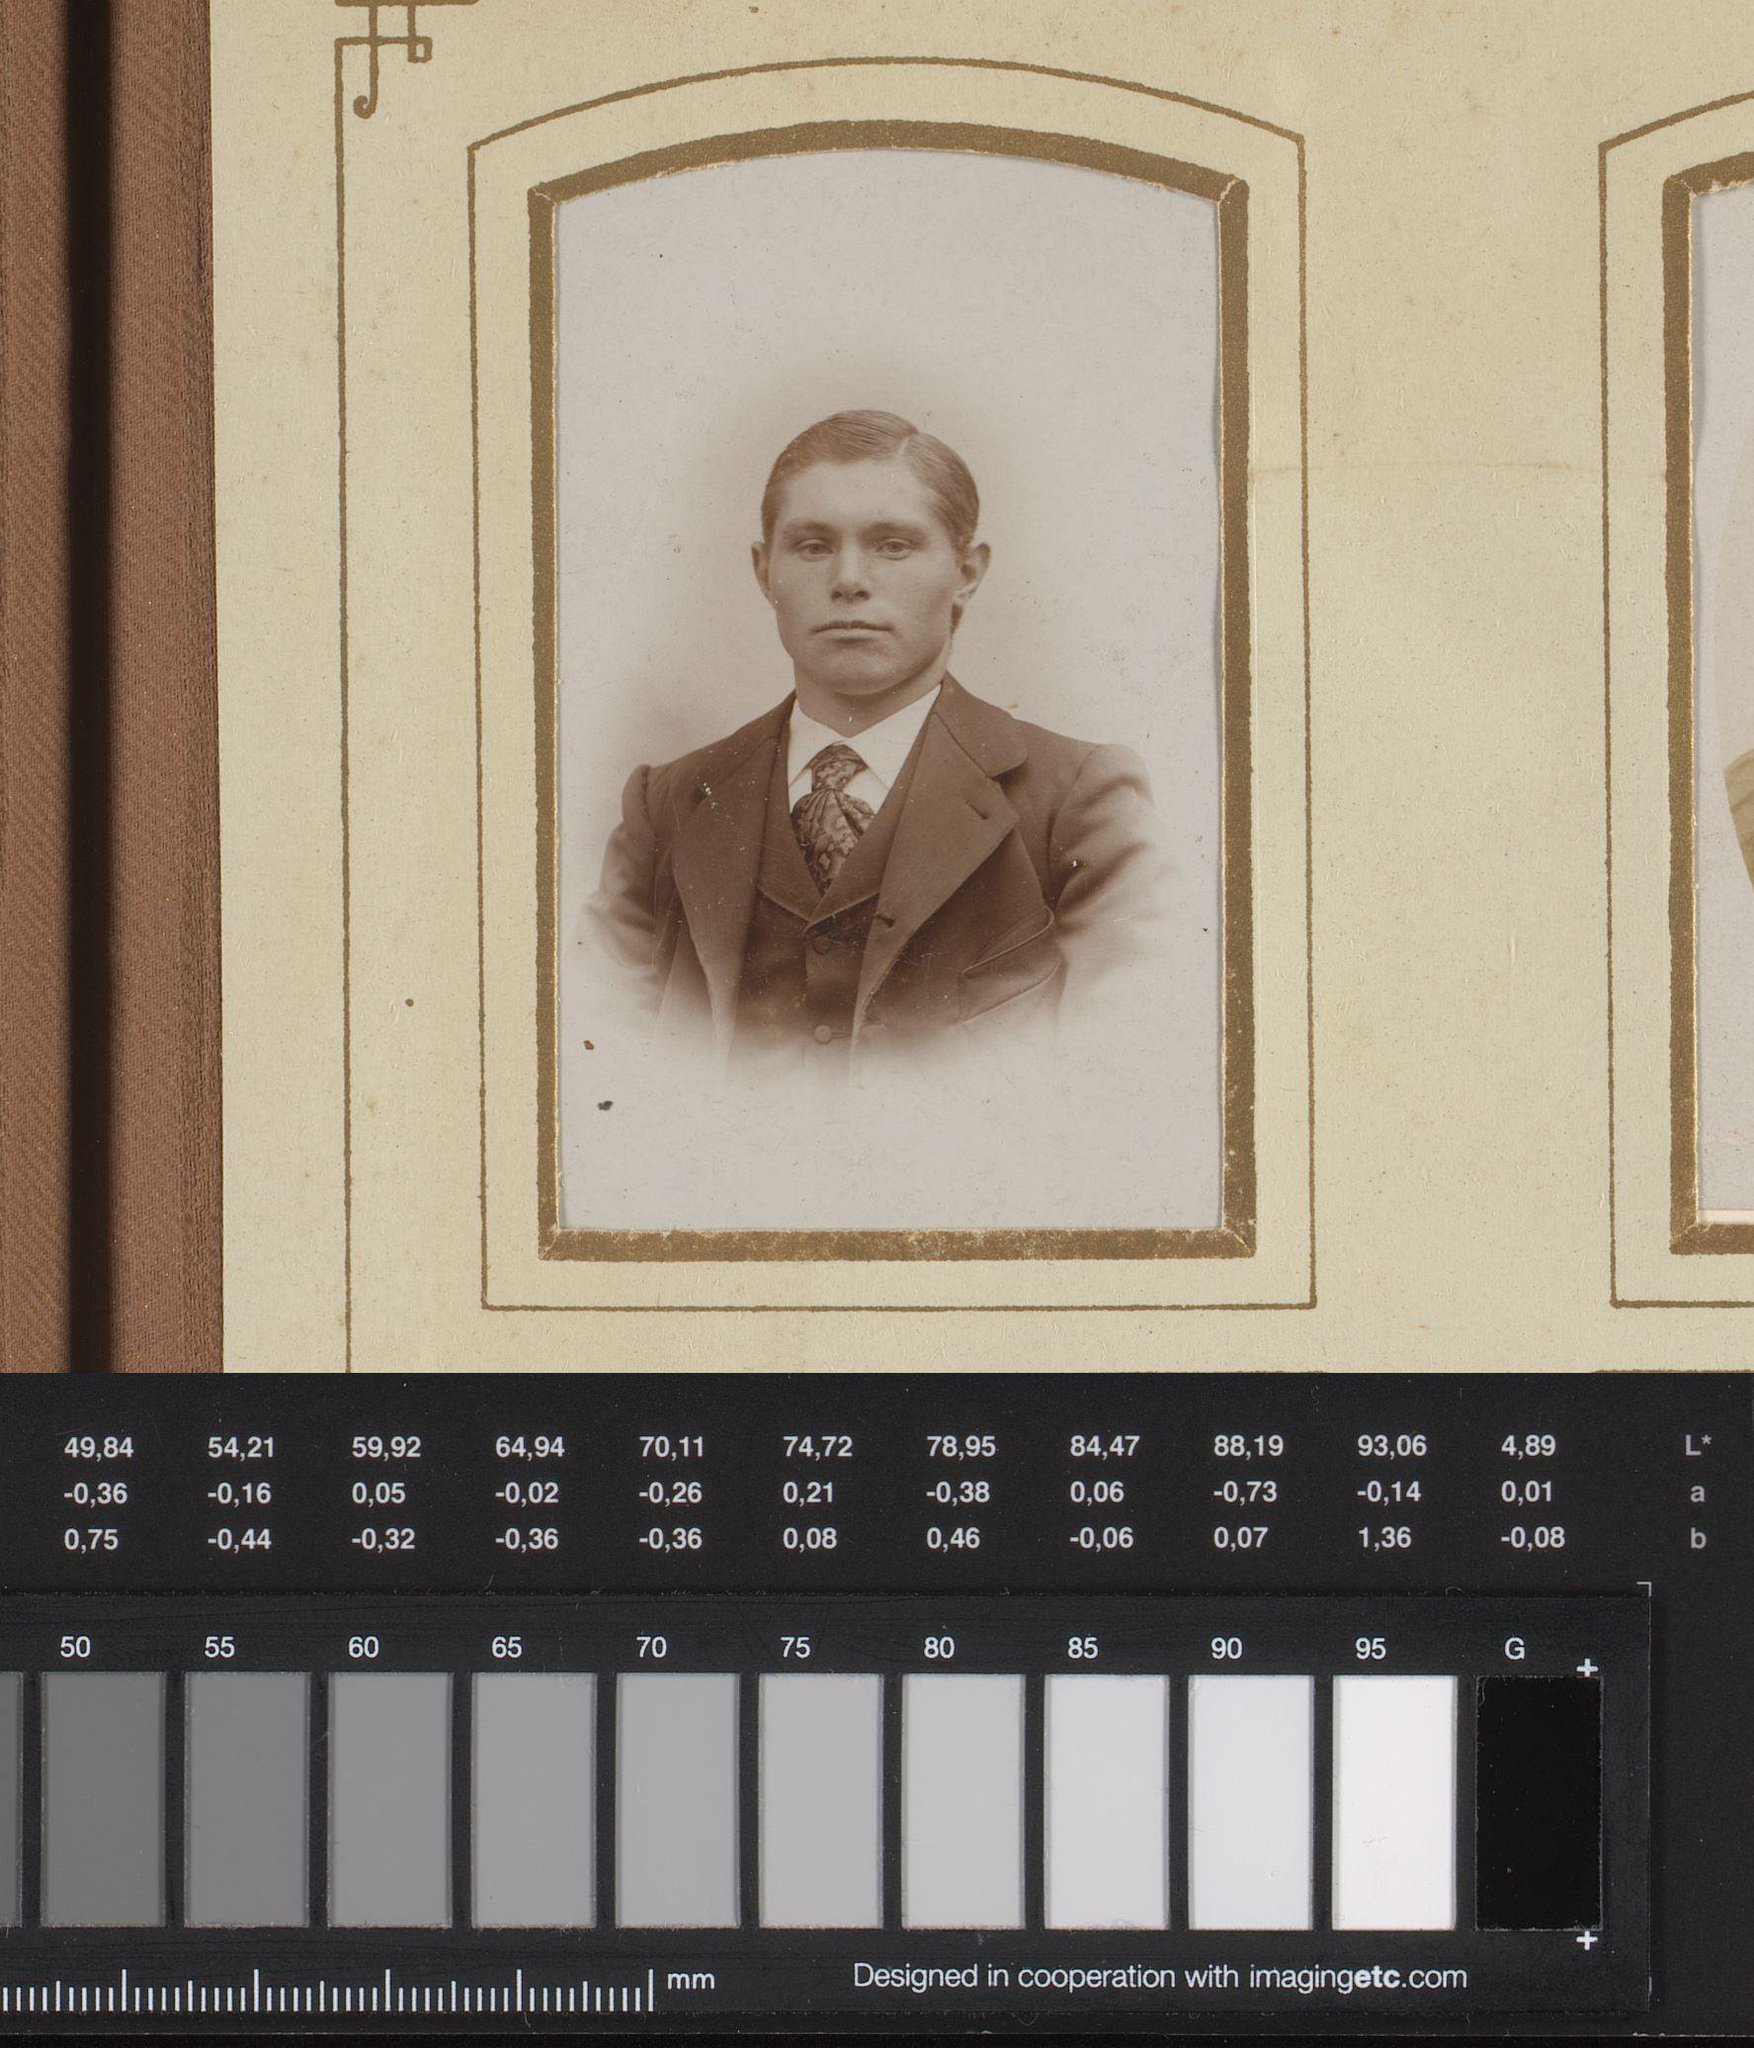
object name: photograph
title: Portret van een man met stropdas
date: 1880-1918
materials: cardboard, photographic support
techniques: collodion silver print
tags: historical persons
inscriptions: inscription: ‘Photographische/ Ateliers/ J. Siewers & Zoon/ Edam/ Hilversum./ Specialiteit in vergrootingen.’